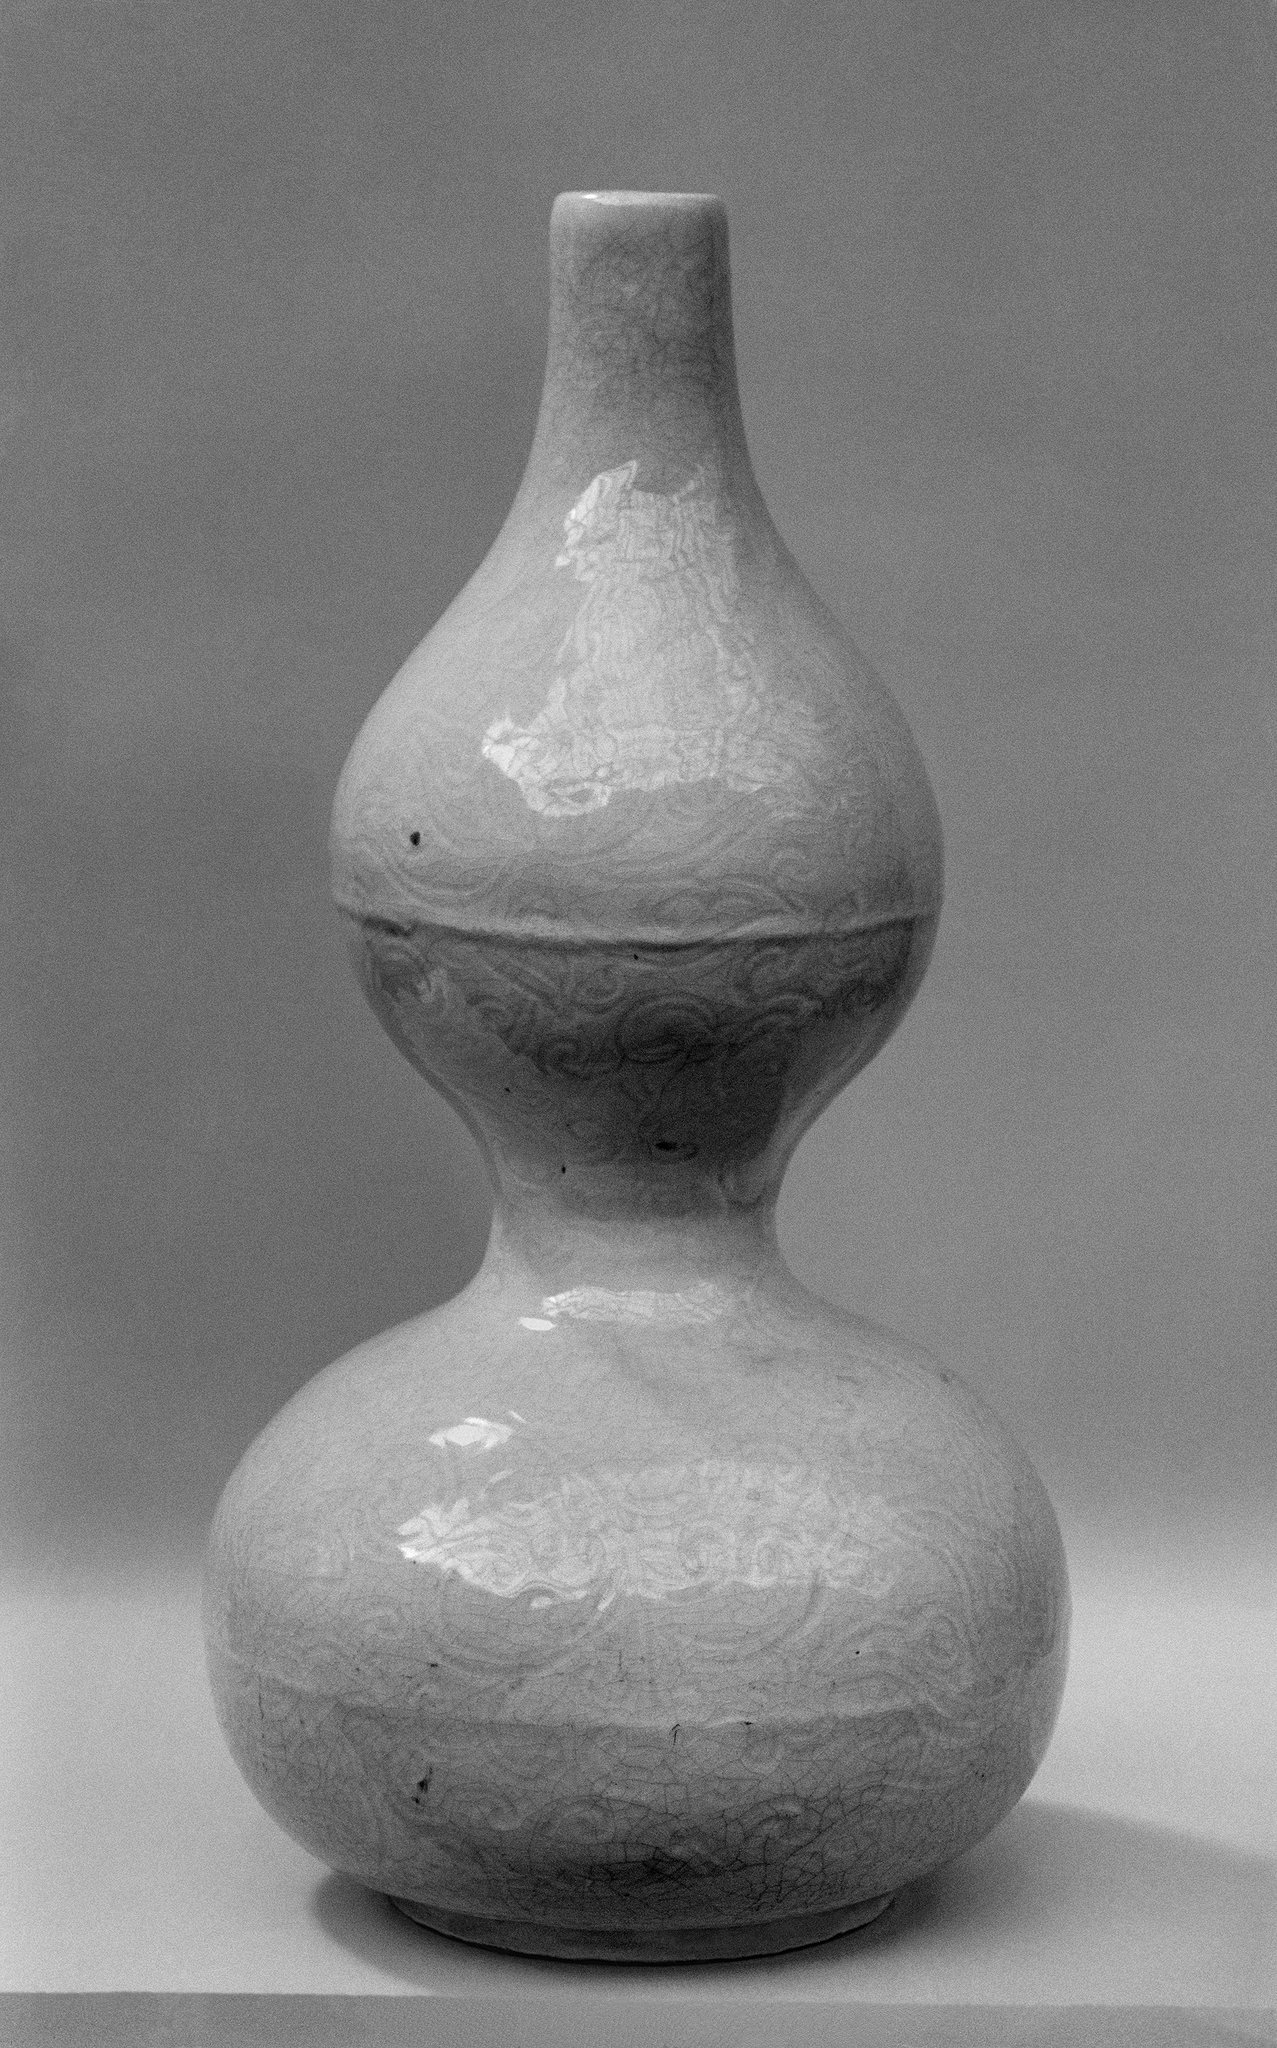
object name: vase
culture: chinese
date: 1368-1644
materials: glaze, porcelain